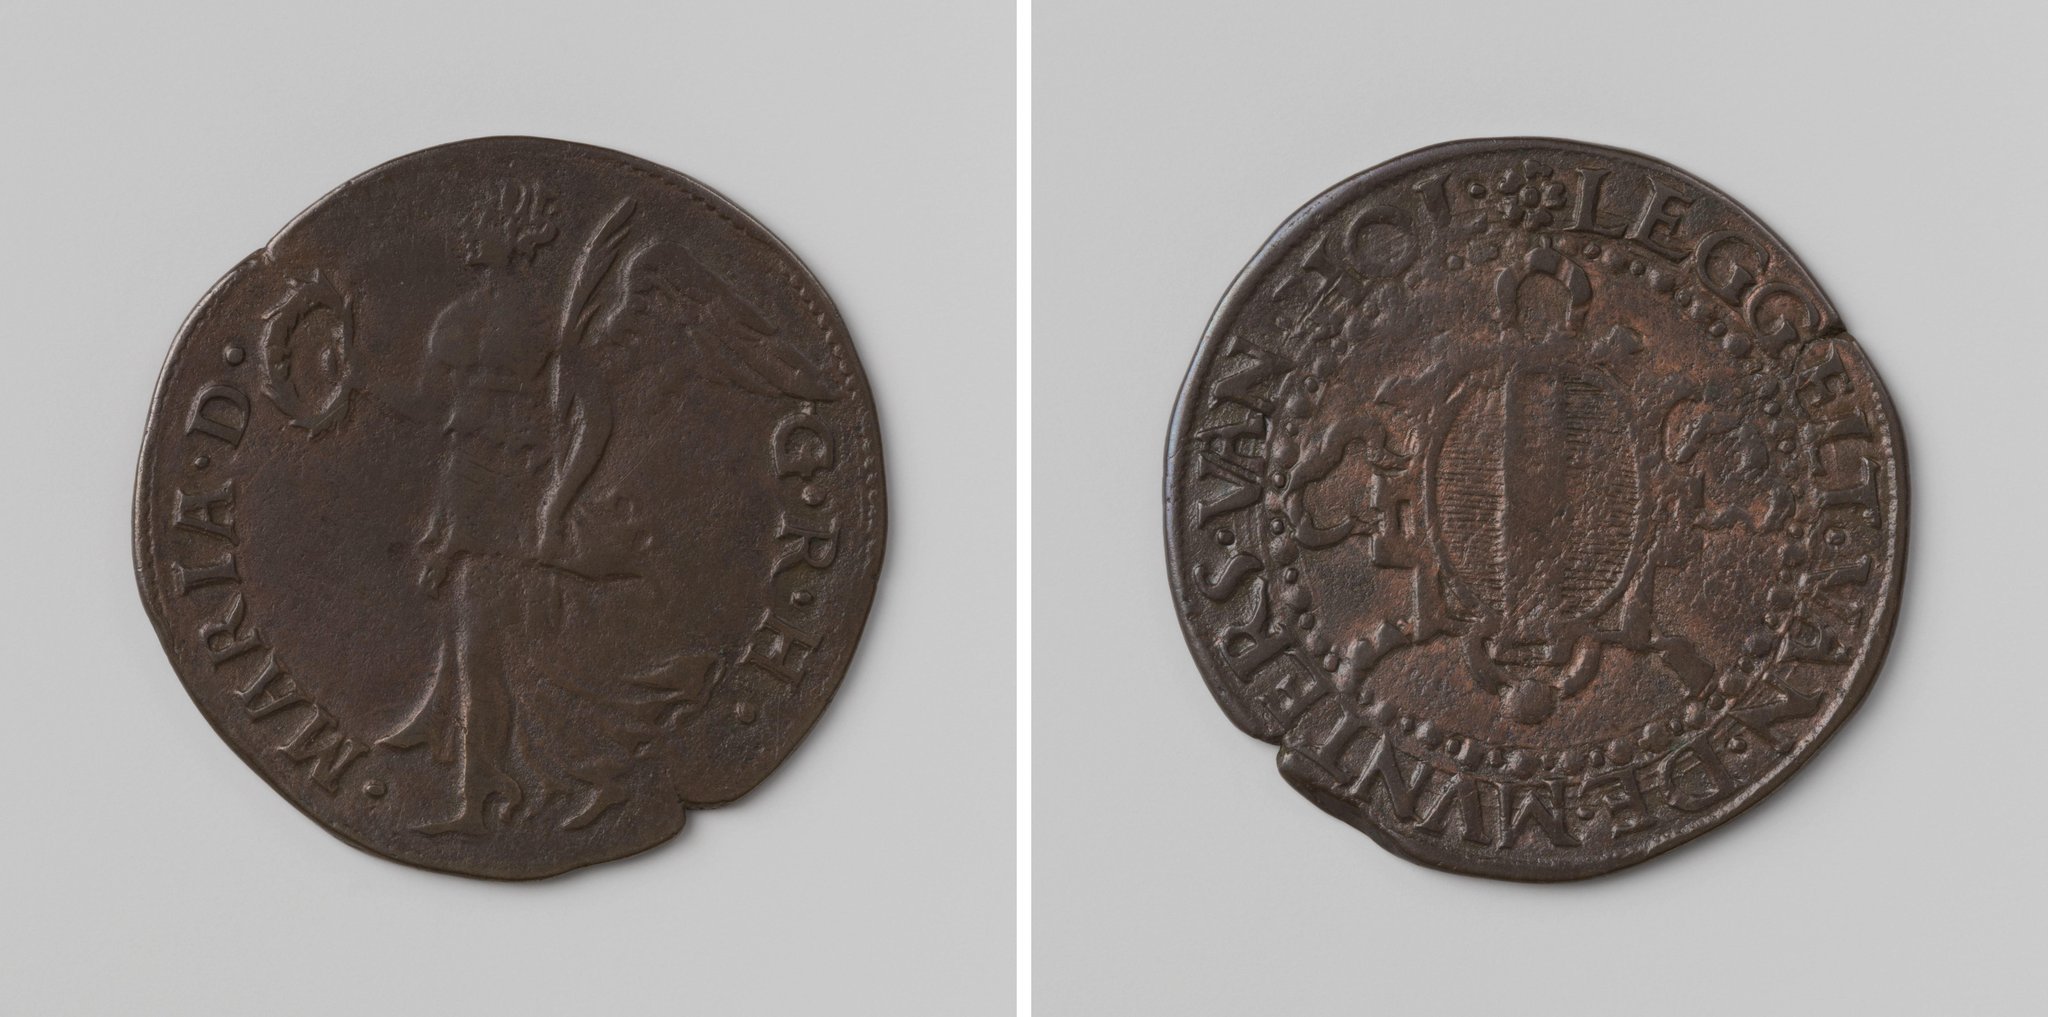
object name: jeton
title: Maria van Hongarije doet te Brussel afstand van de voogdij over de Nederlanden, ten gunst van Filips, erfprins van Spanje, rekenpenning van de munt van Holland te Dordrecht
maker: Anonymous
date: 1555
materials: copper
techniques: striking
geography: dordrecht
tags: philip ii of spain, brussels, maria van hongarije (landvoogdes der nederlanden), dordrecht, low countries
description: Koperen penning. Voorzijde: gevleugelde Overwinning met lauwerkrans in rechter- en palmtak in linkerhand binnen omschrift. Keerzijde: wapenschild in cartouche binnen omschrift